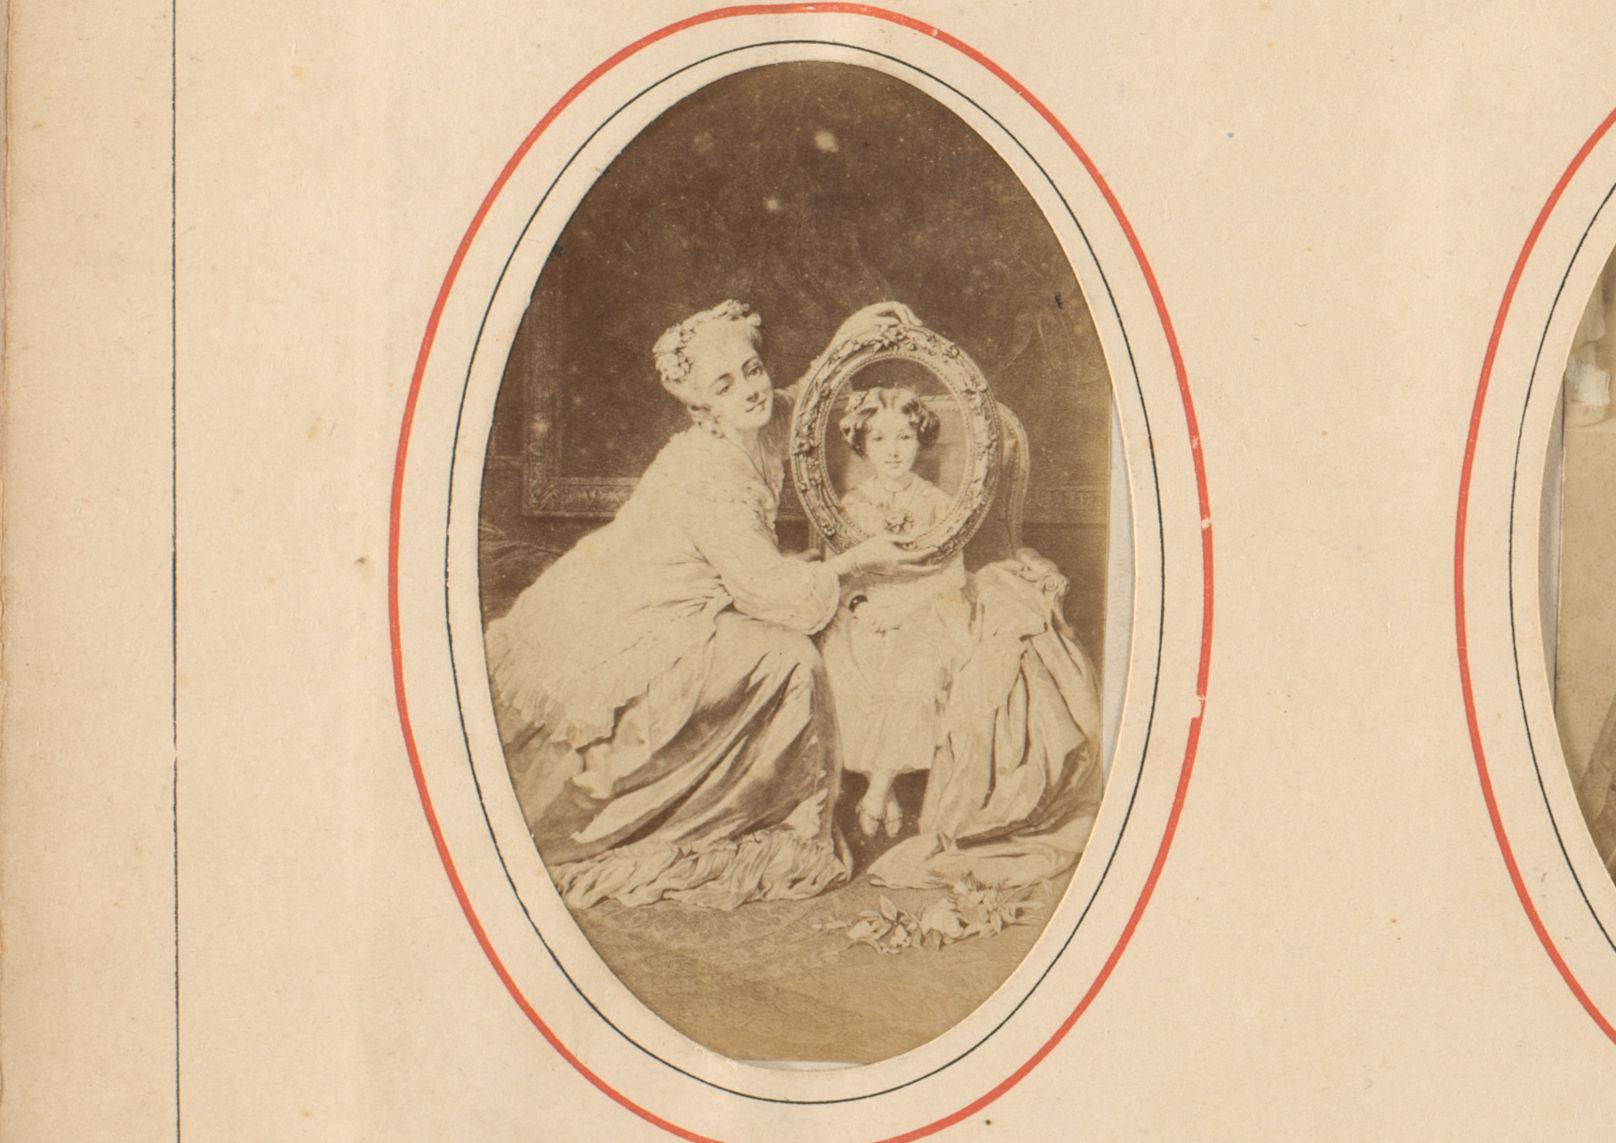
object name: carte de visite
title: Fotoreproductie van een schilderij, vrouw houdt lijst voor gezicht van dochter, naar Felix Schlesinger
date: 1870-1890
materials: cardboard, paper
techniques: albumen print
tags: mother and baby or young child, frame of painting, etc.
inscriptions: number: ‘713’